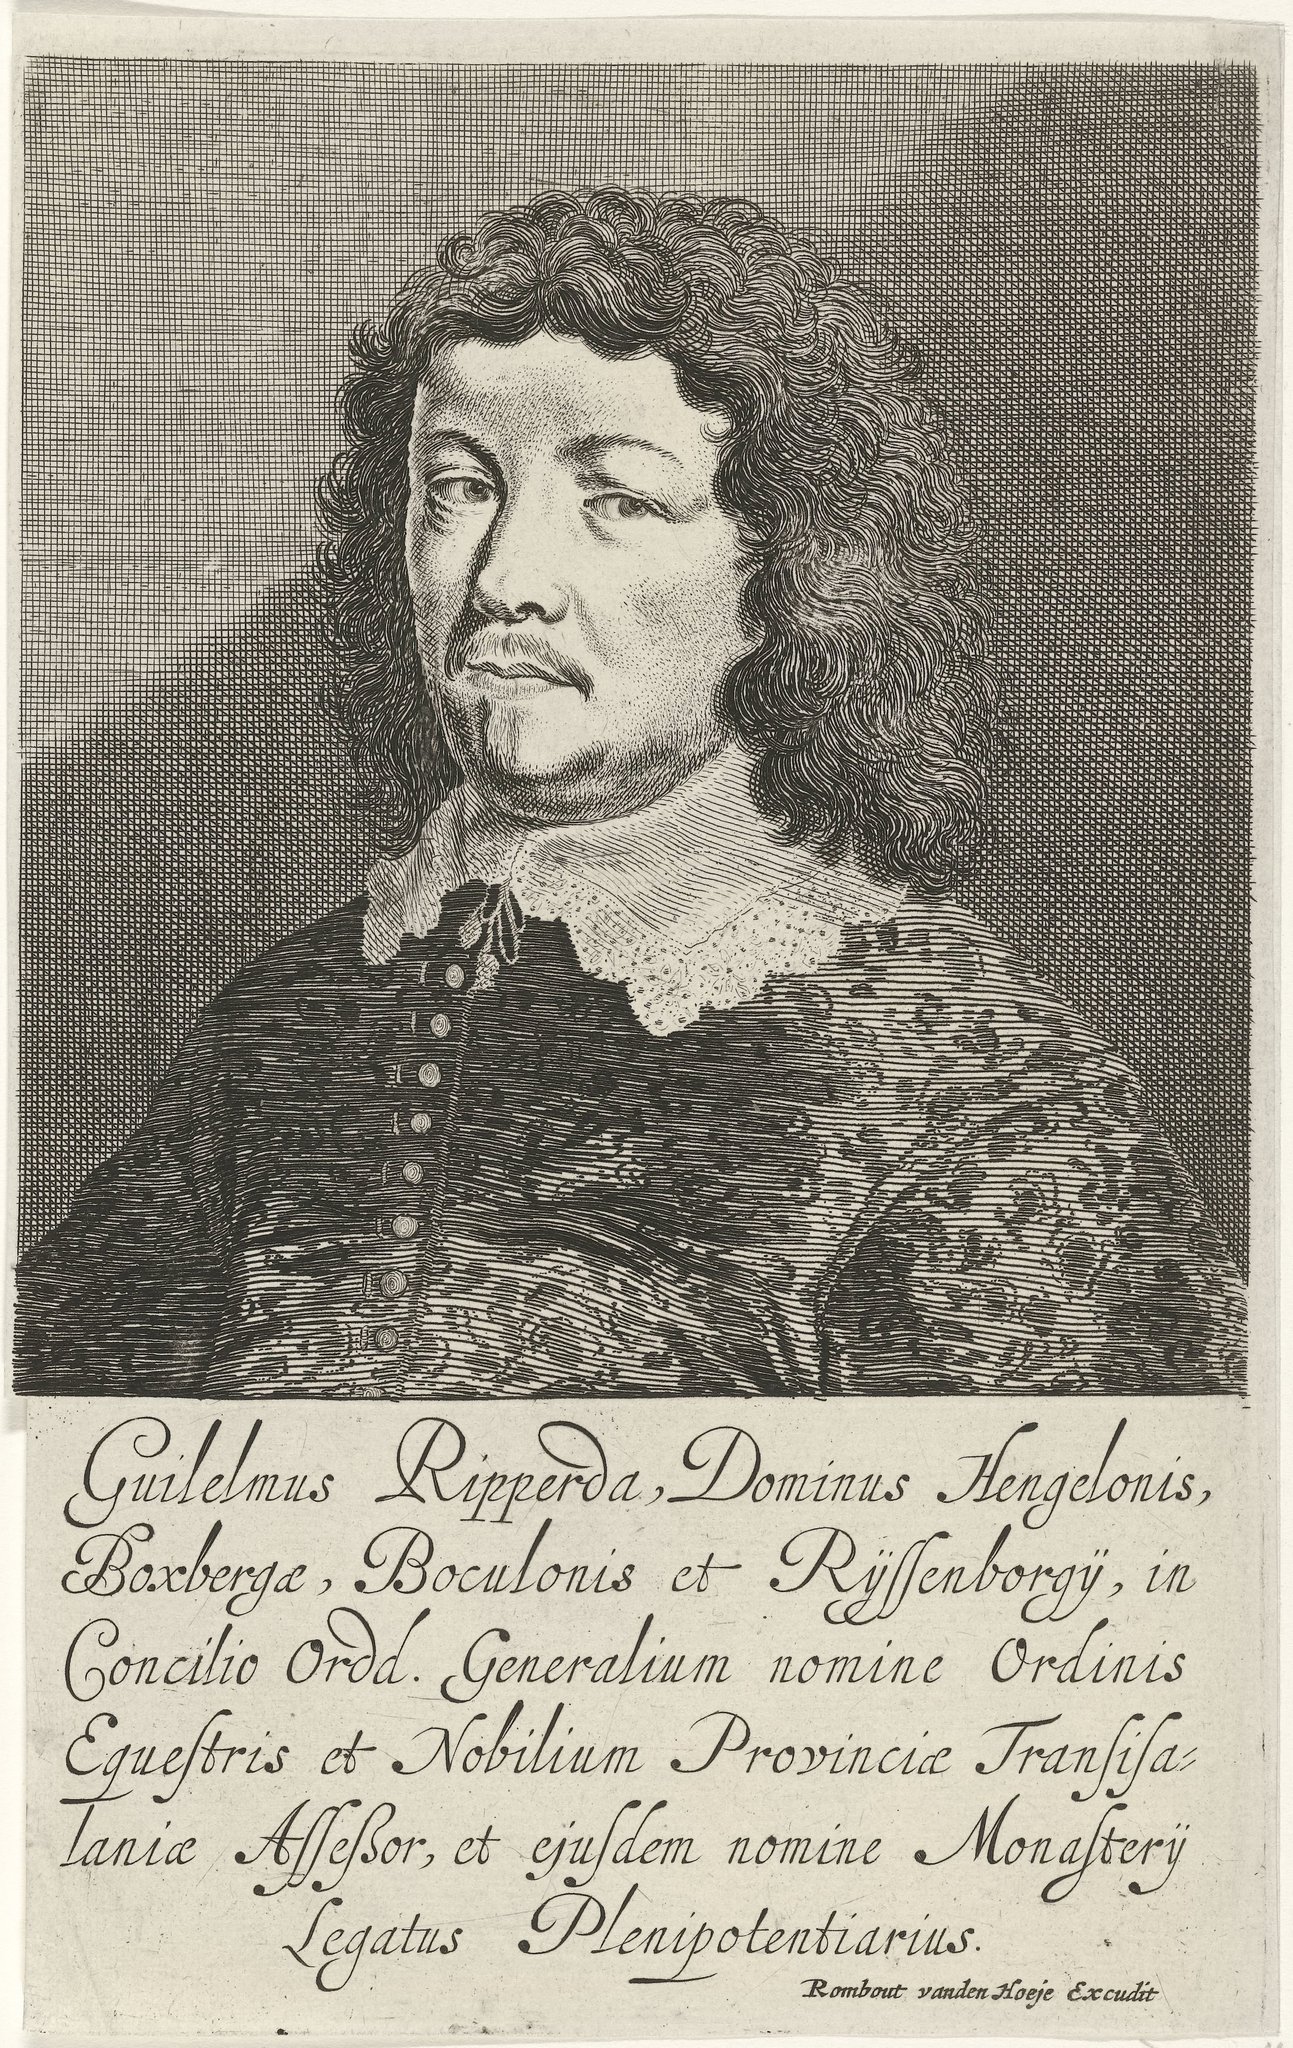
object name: print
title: Portret van Willem van Ripperda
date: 1644-1664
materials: paper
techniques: engraving, etching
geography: amsterdam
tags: willem van ripperda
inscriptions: collector's mark: Lugt 2228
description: Portret van Willem van Ripperda, onderhandelaar bij de Vrede van Munster. Buste naar links. Onderaan in de marge een zesregelige tekst in het Latijn.